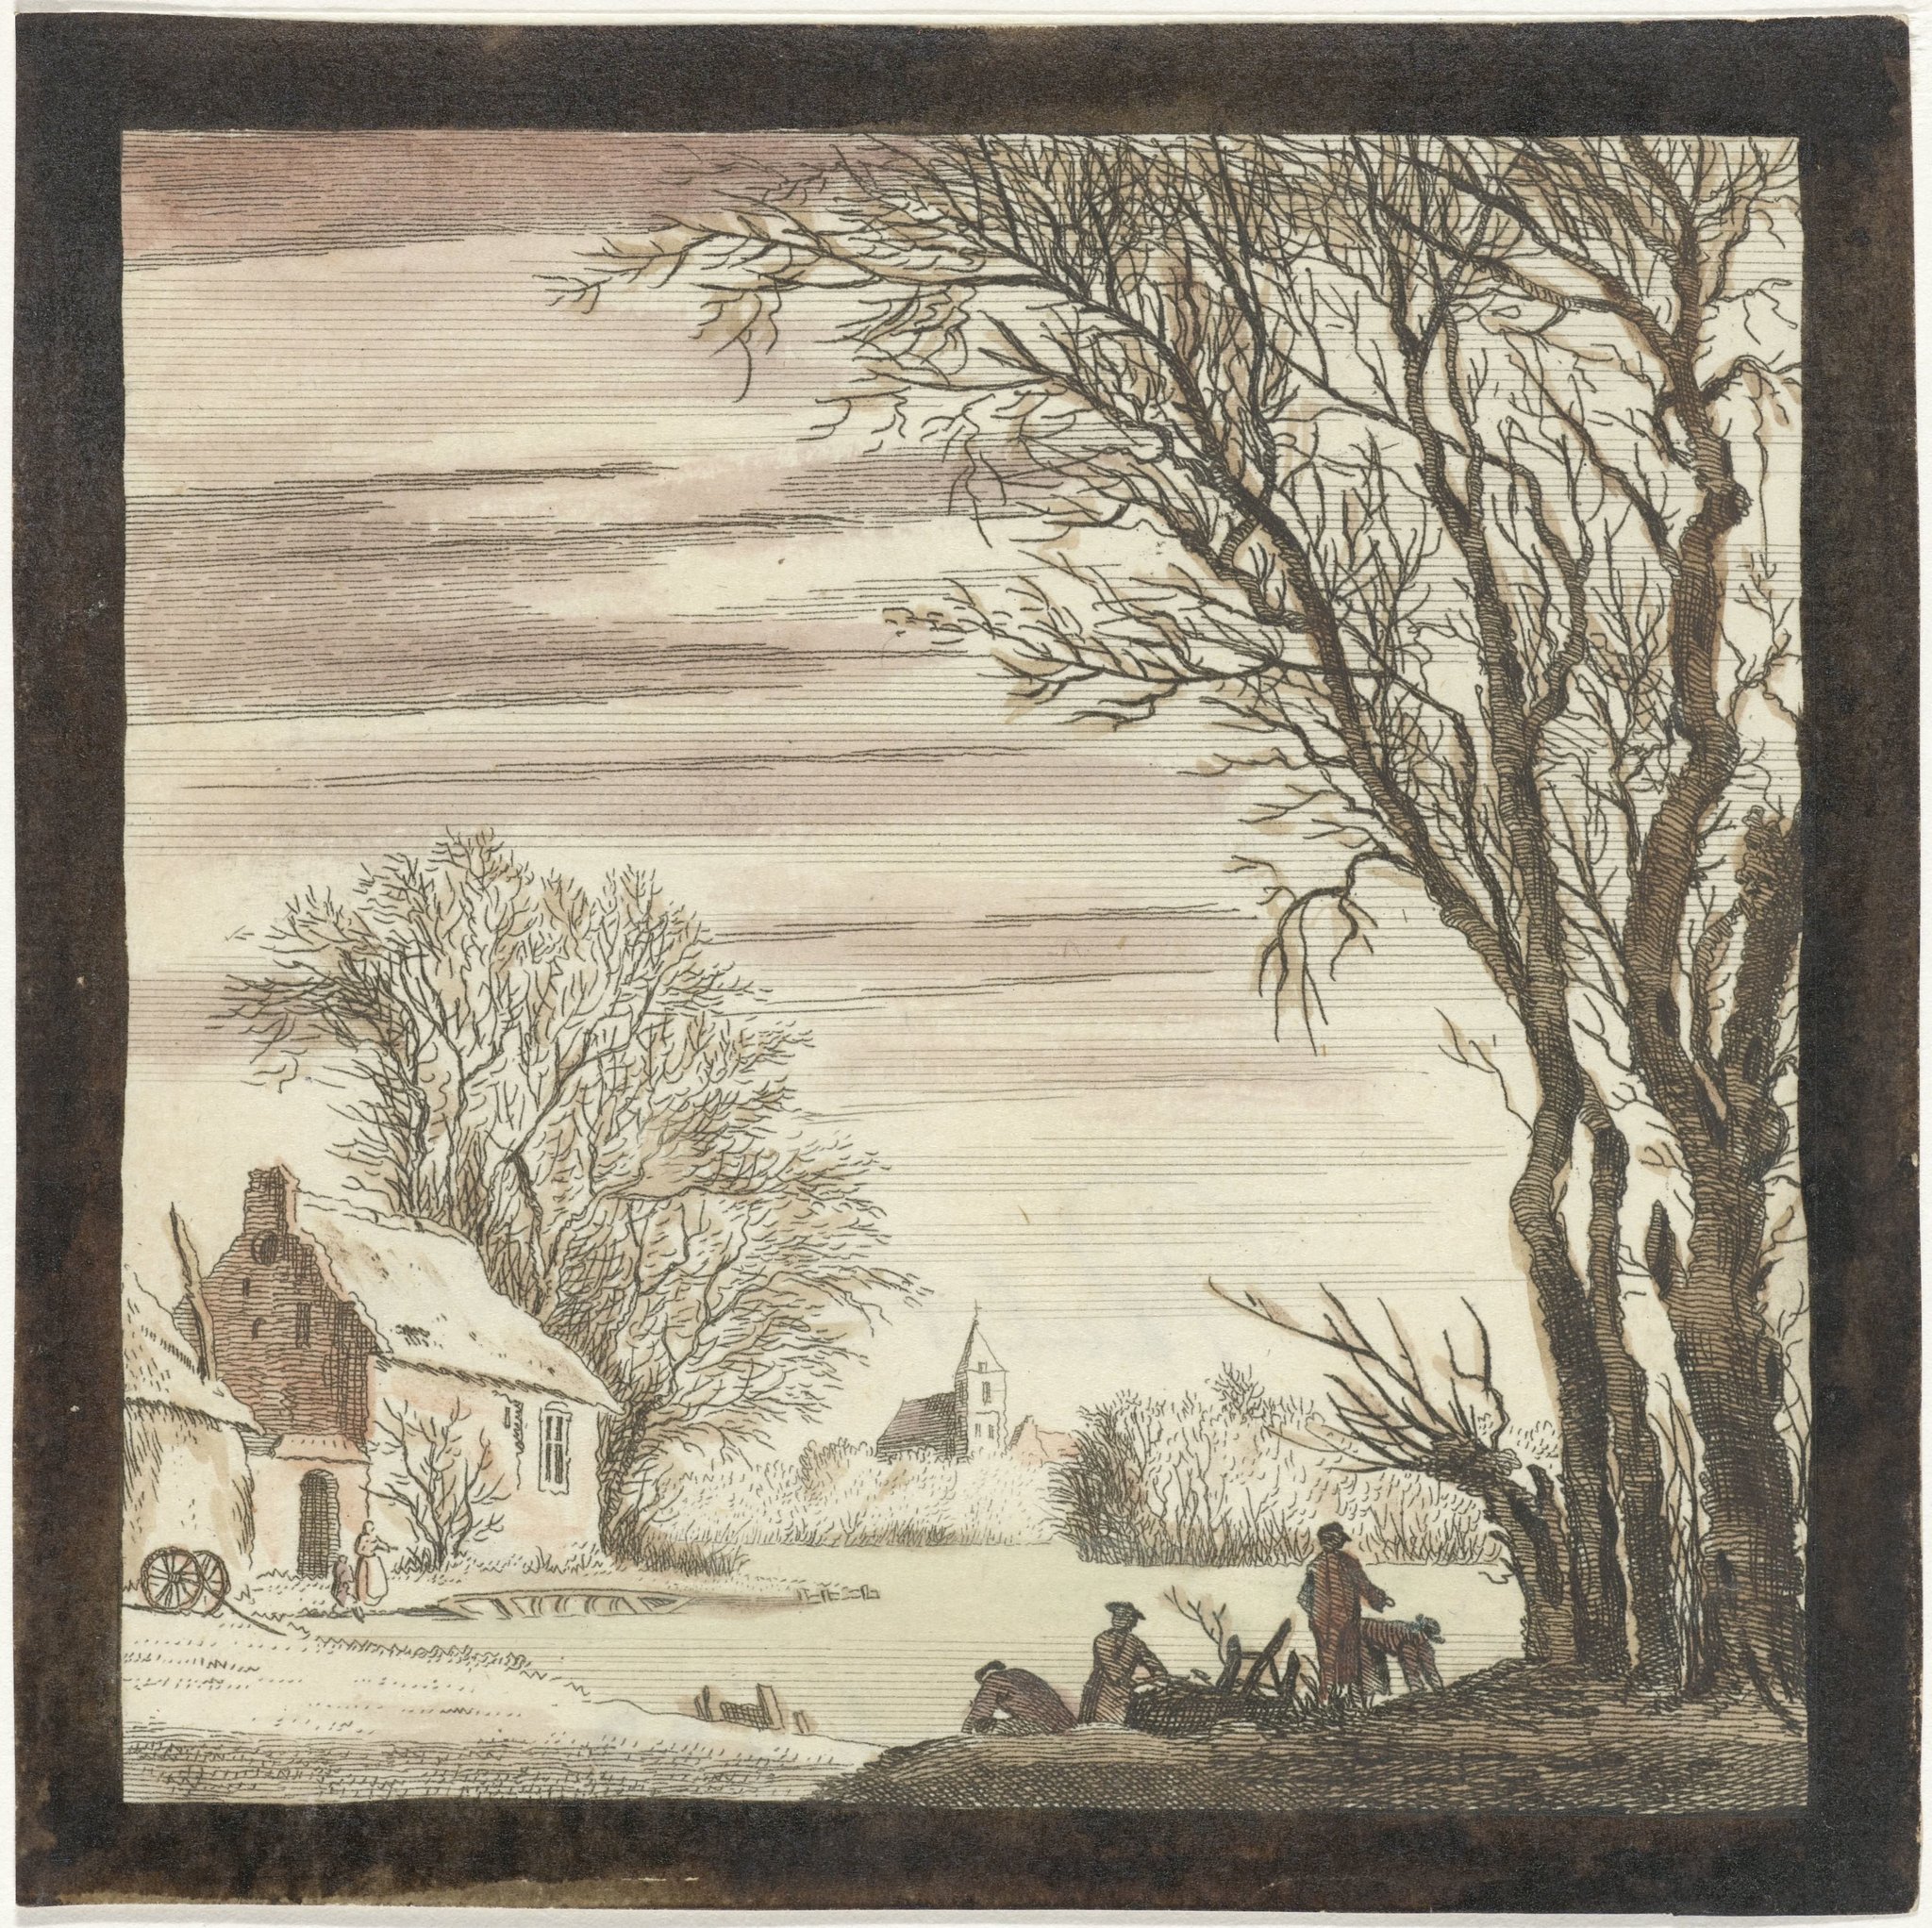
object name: print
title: Winterlandschap met figuren op de oever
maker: paulus van liender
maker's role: draughtsman, print maker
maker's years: 1731-1797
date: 1741-1797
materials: paper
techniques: etching, hand coloring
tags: winter landscape; landscape symbolizing winter (the four seasons of the year), skates (winter sports), farm or solitary house in landscape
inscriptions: collector's mark: Lugt 240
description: Winterlandschap met boerderij. Rechts op de voorgrond binden figuren hun schaatsen onder